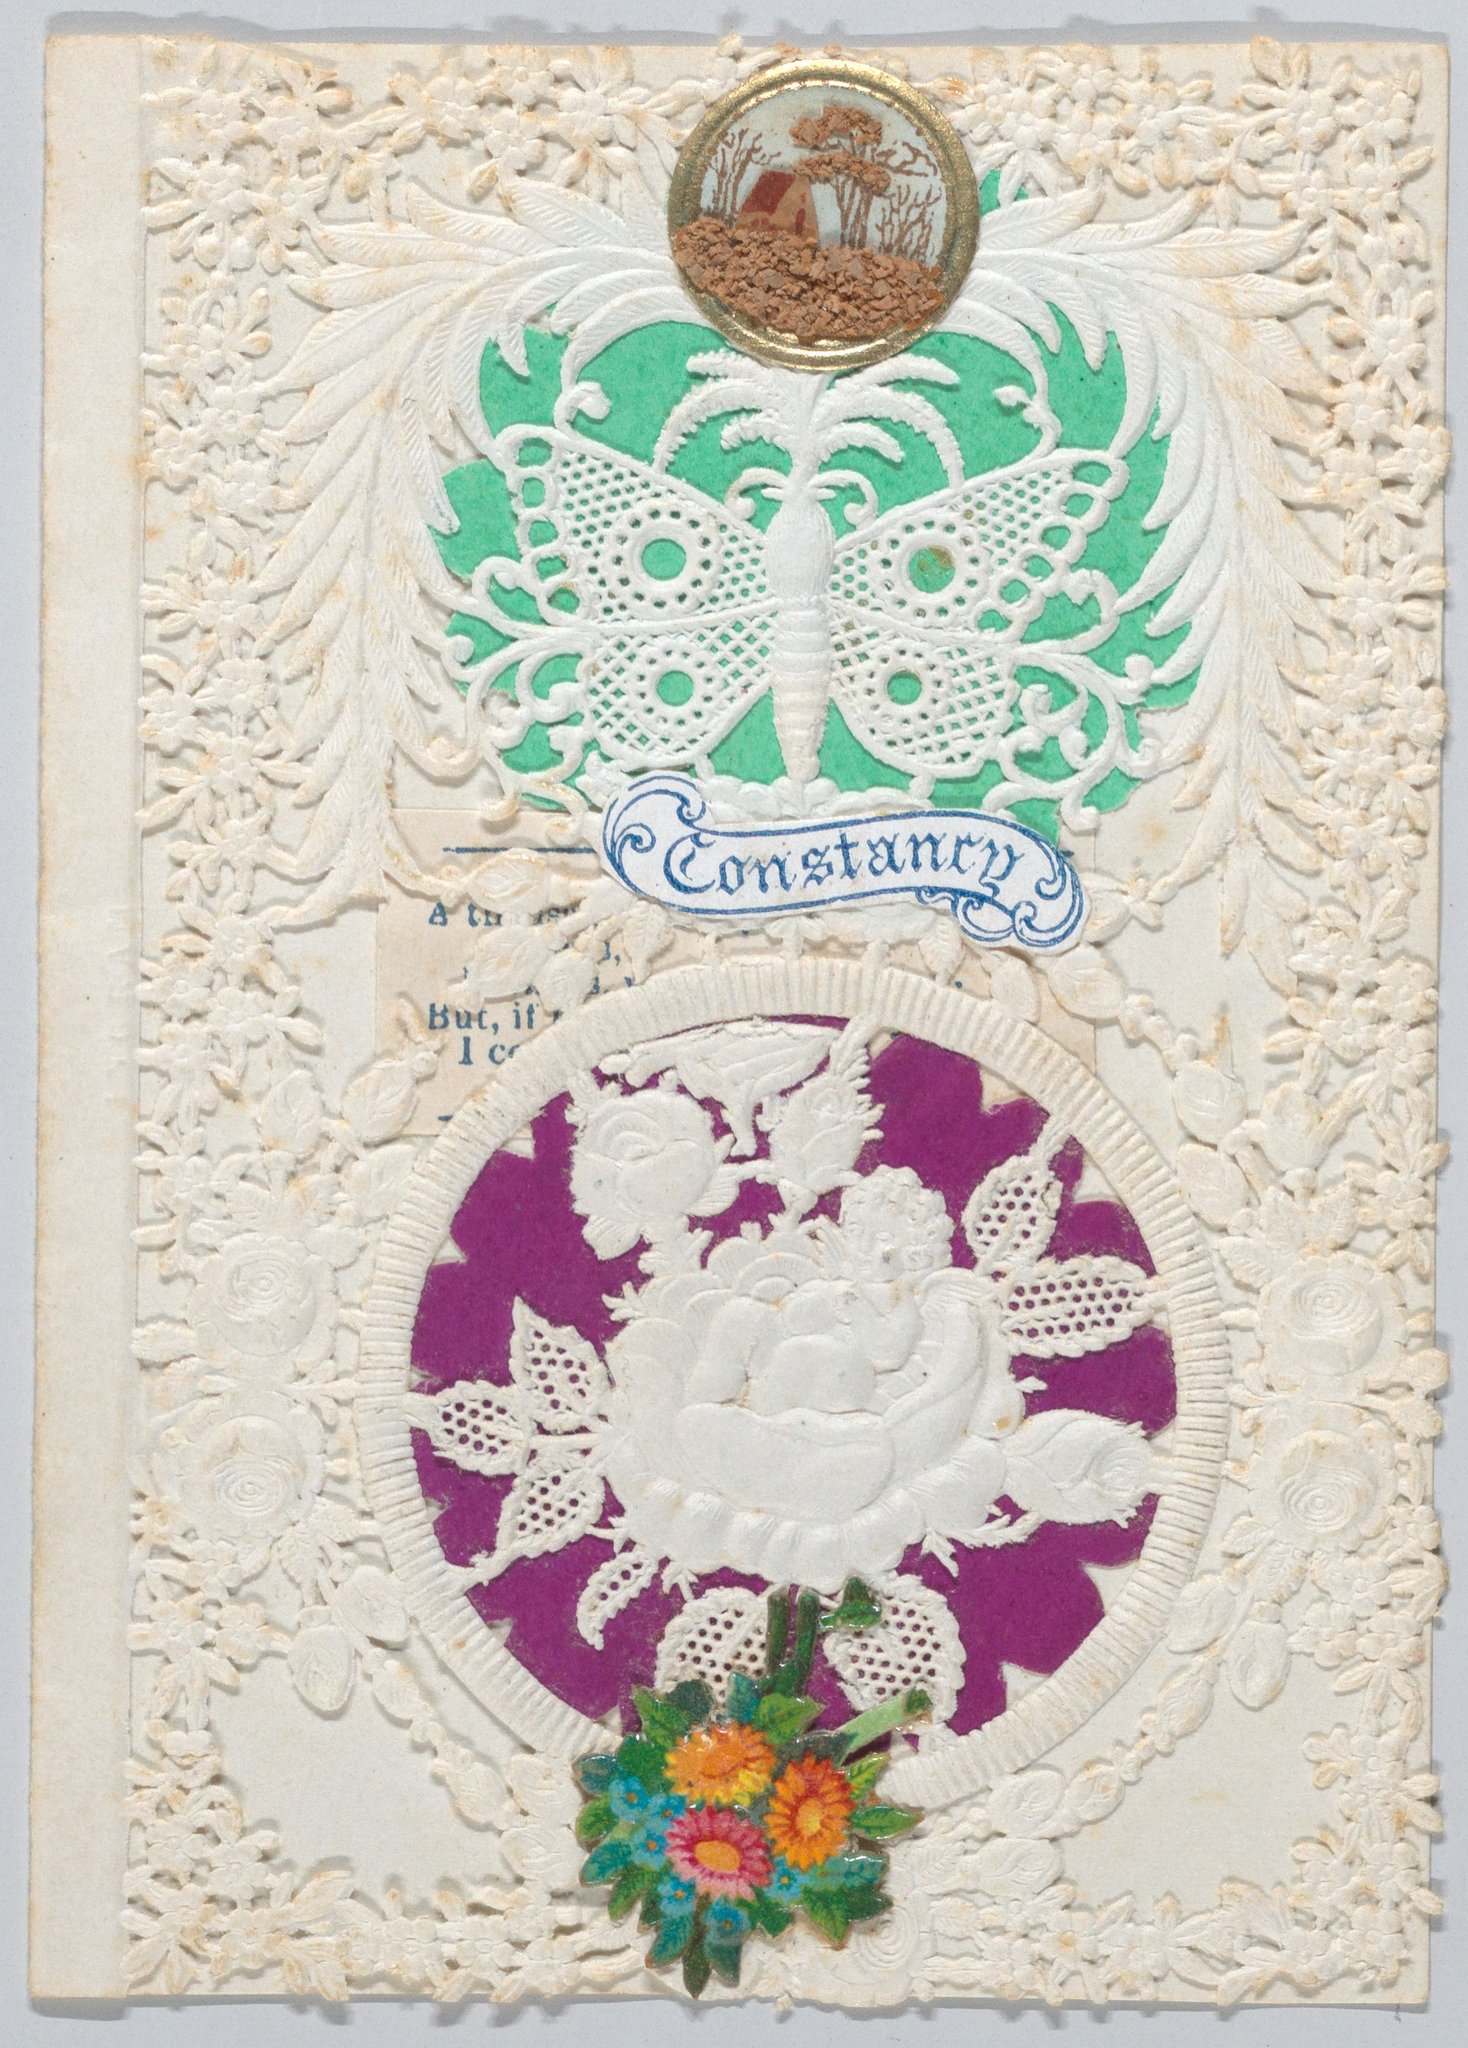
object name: valentine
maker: Anonymous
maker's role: artist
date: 1847-1870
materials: cork, lace, paper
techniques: chromolithography, embossing, open work